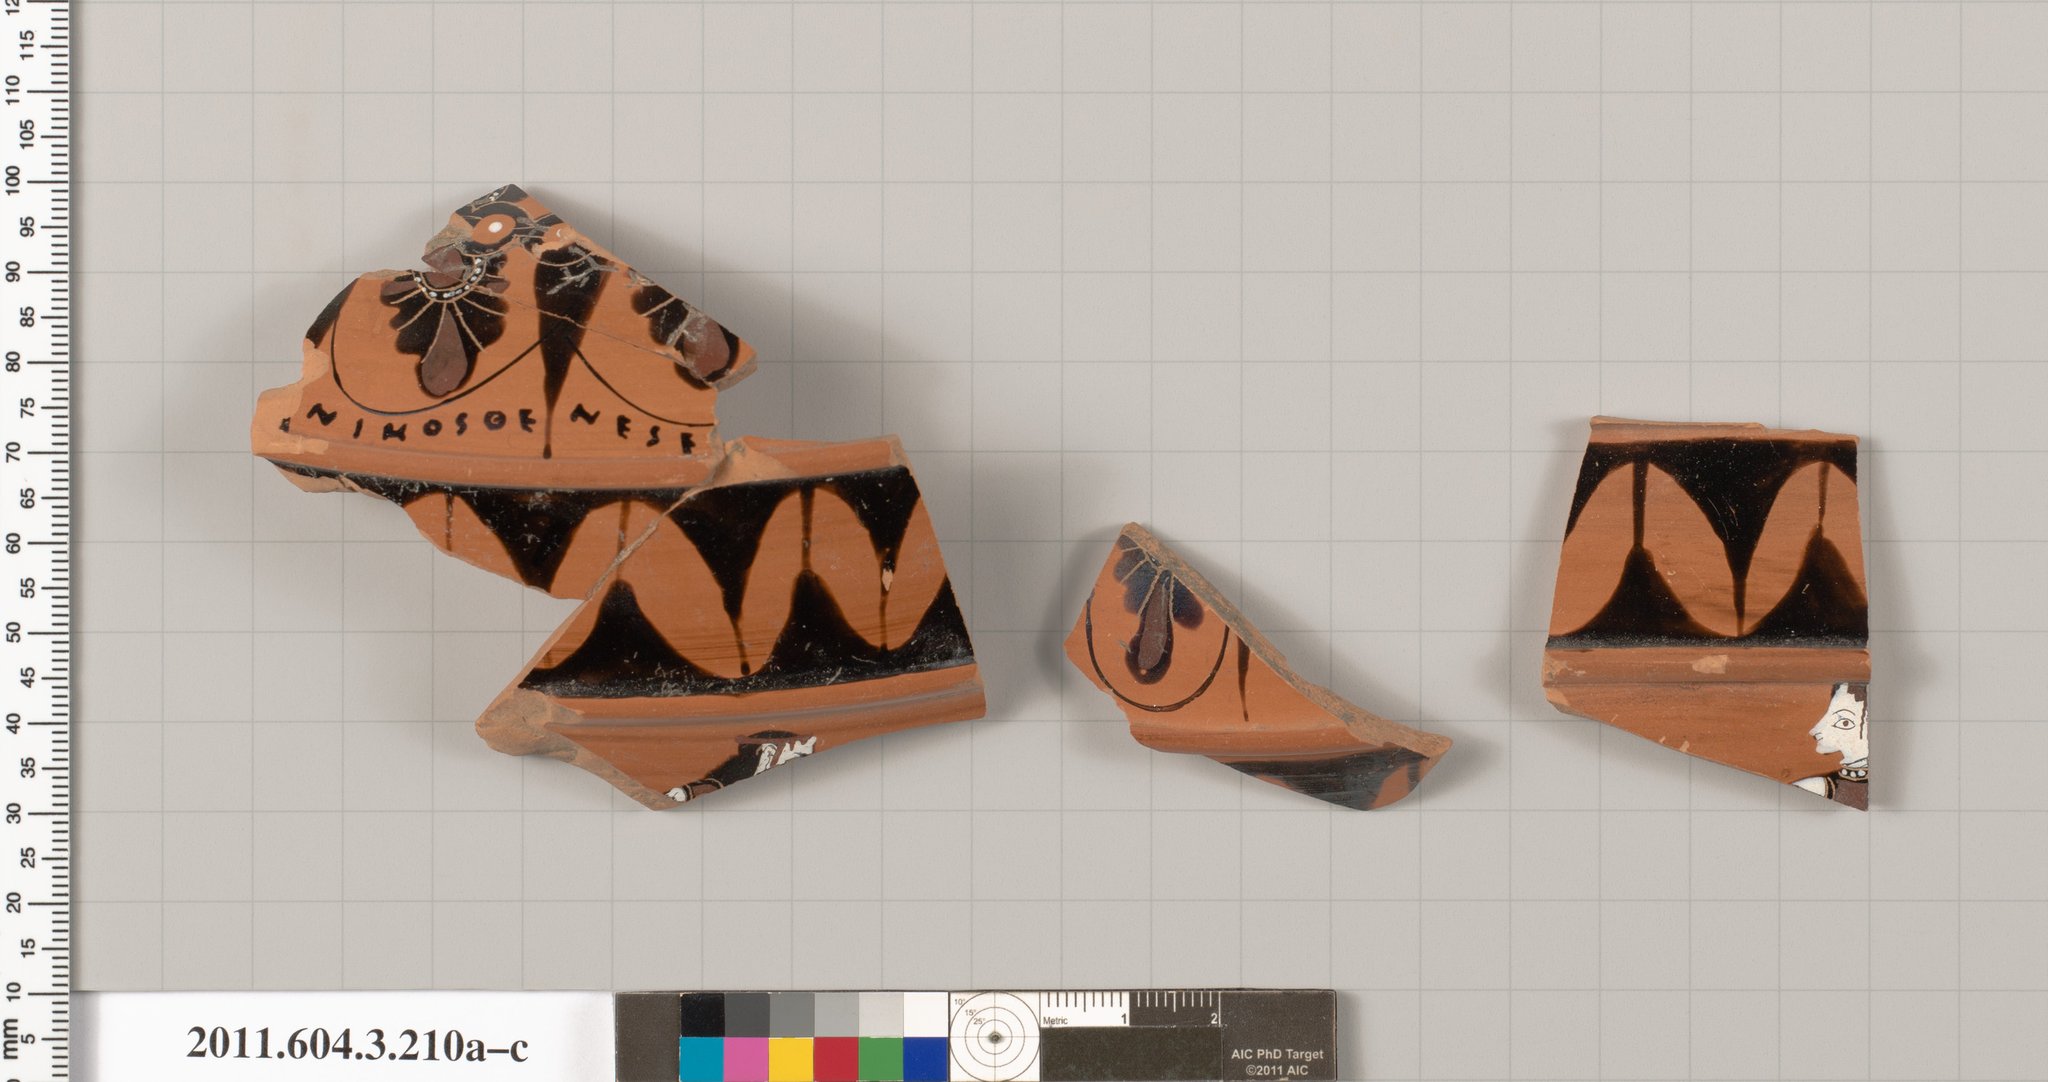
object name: neck amphora fragment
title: Terracotta fragments of a neck-amphora of Nicosthenic shape (jar)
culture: greek, attic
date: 525-501 BCE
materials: terracotta